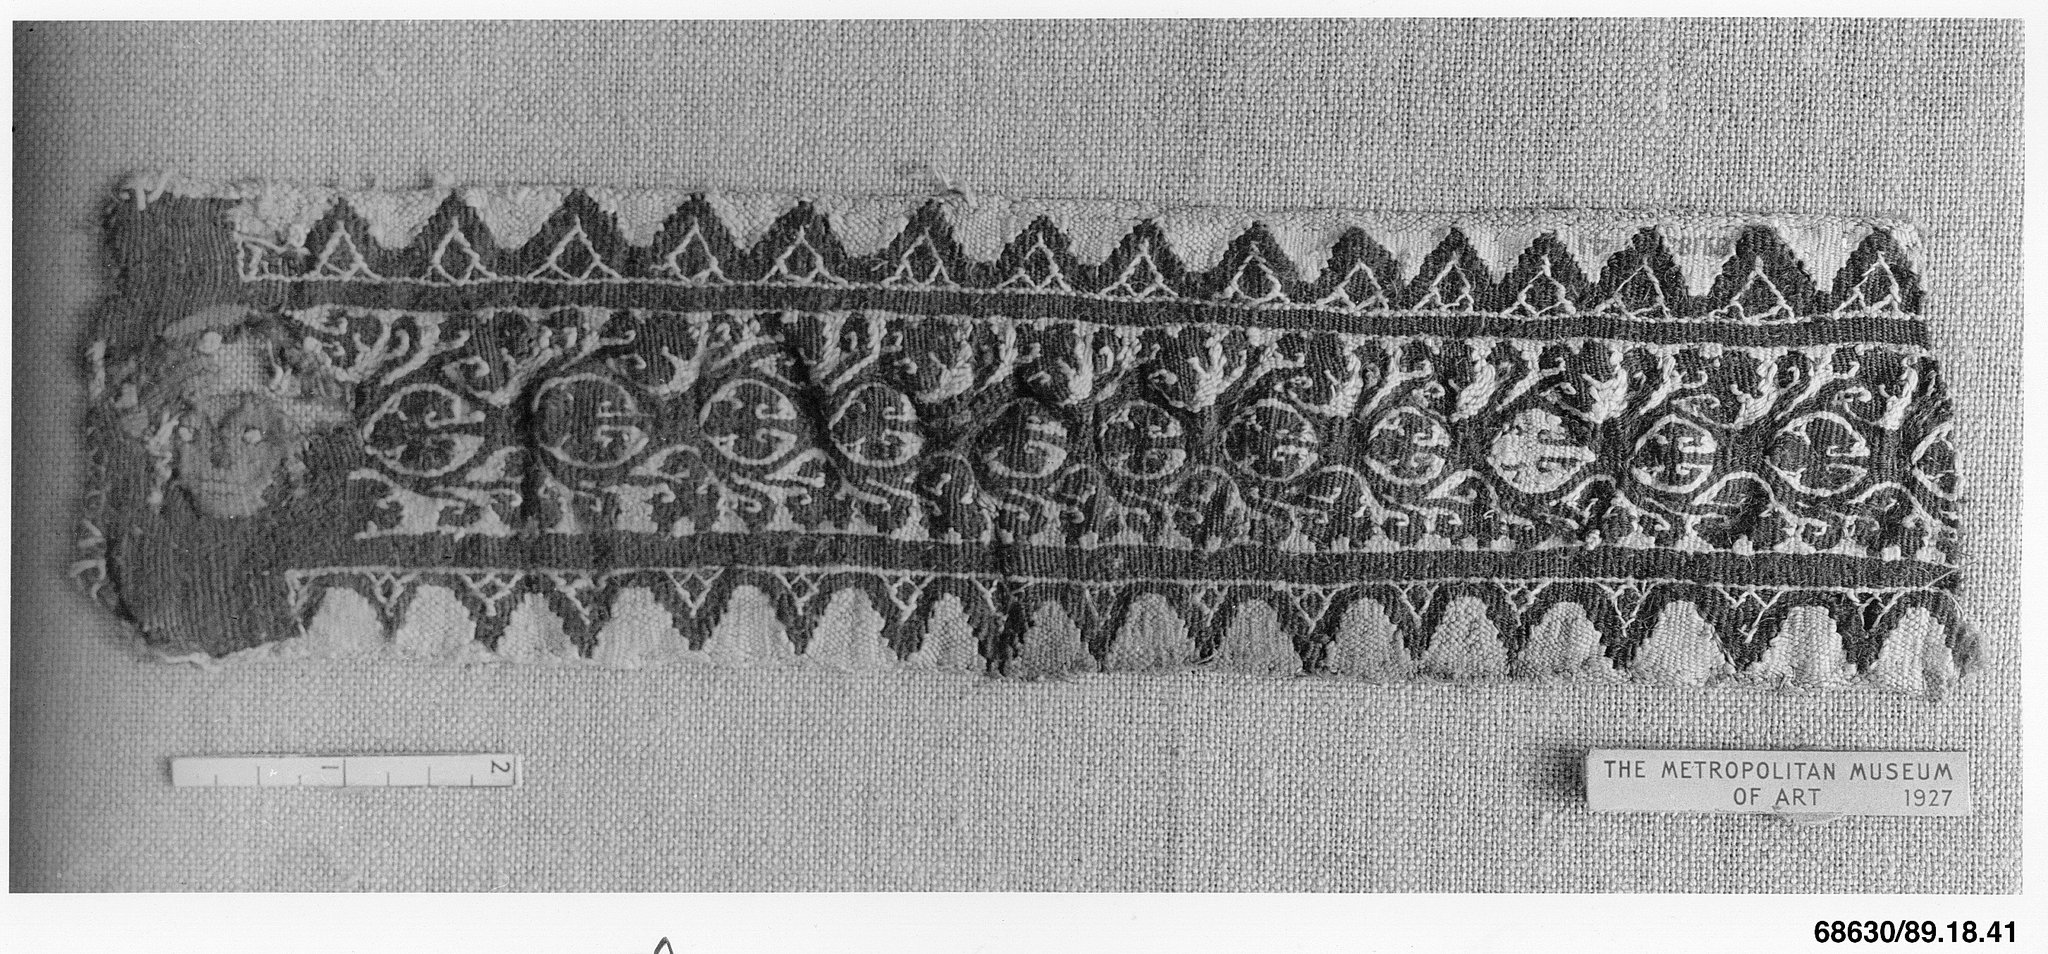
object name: textile fragment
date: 201-400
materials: linen, wool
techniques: weave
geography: egypt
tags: faces